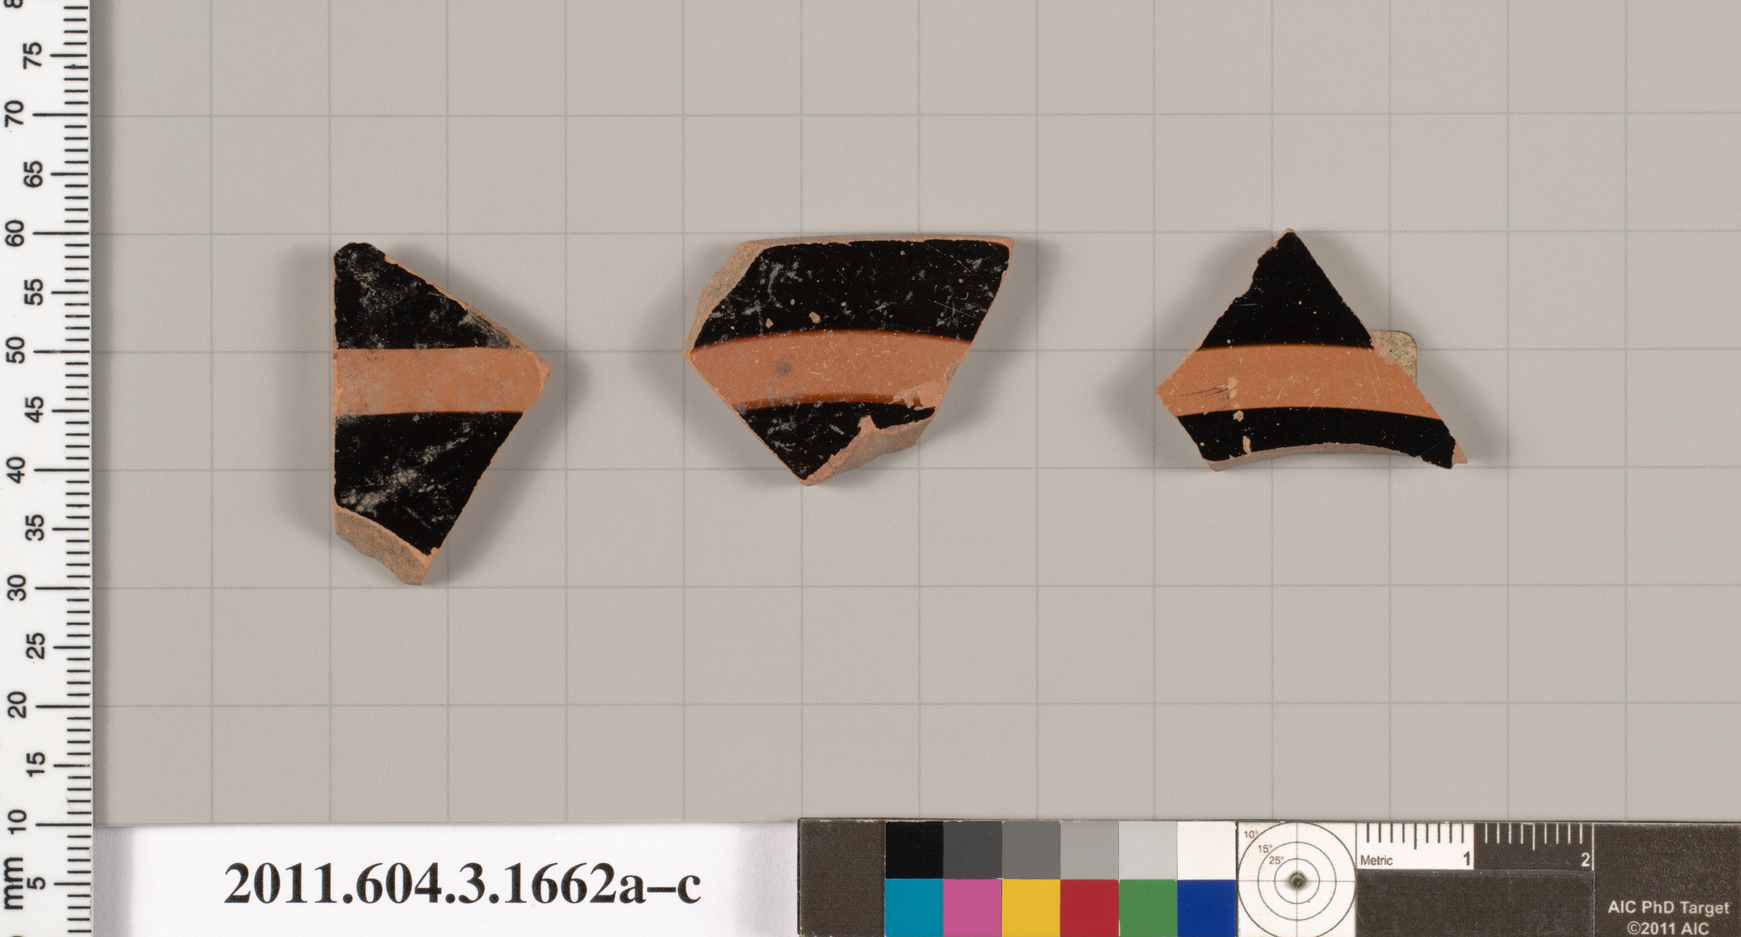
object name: kylix fragment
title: Terracotta fragments of kylikes: Band or lip cups (drinking cups)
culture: greek, attic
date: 550-526 BCE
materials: terracotta